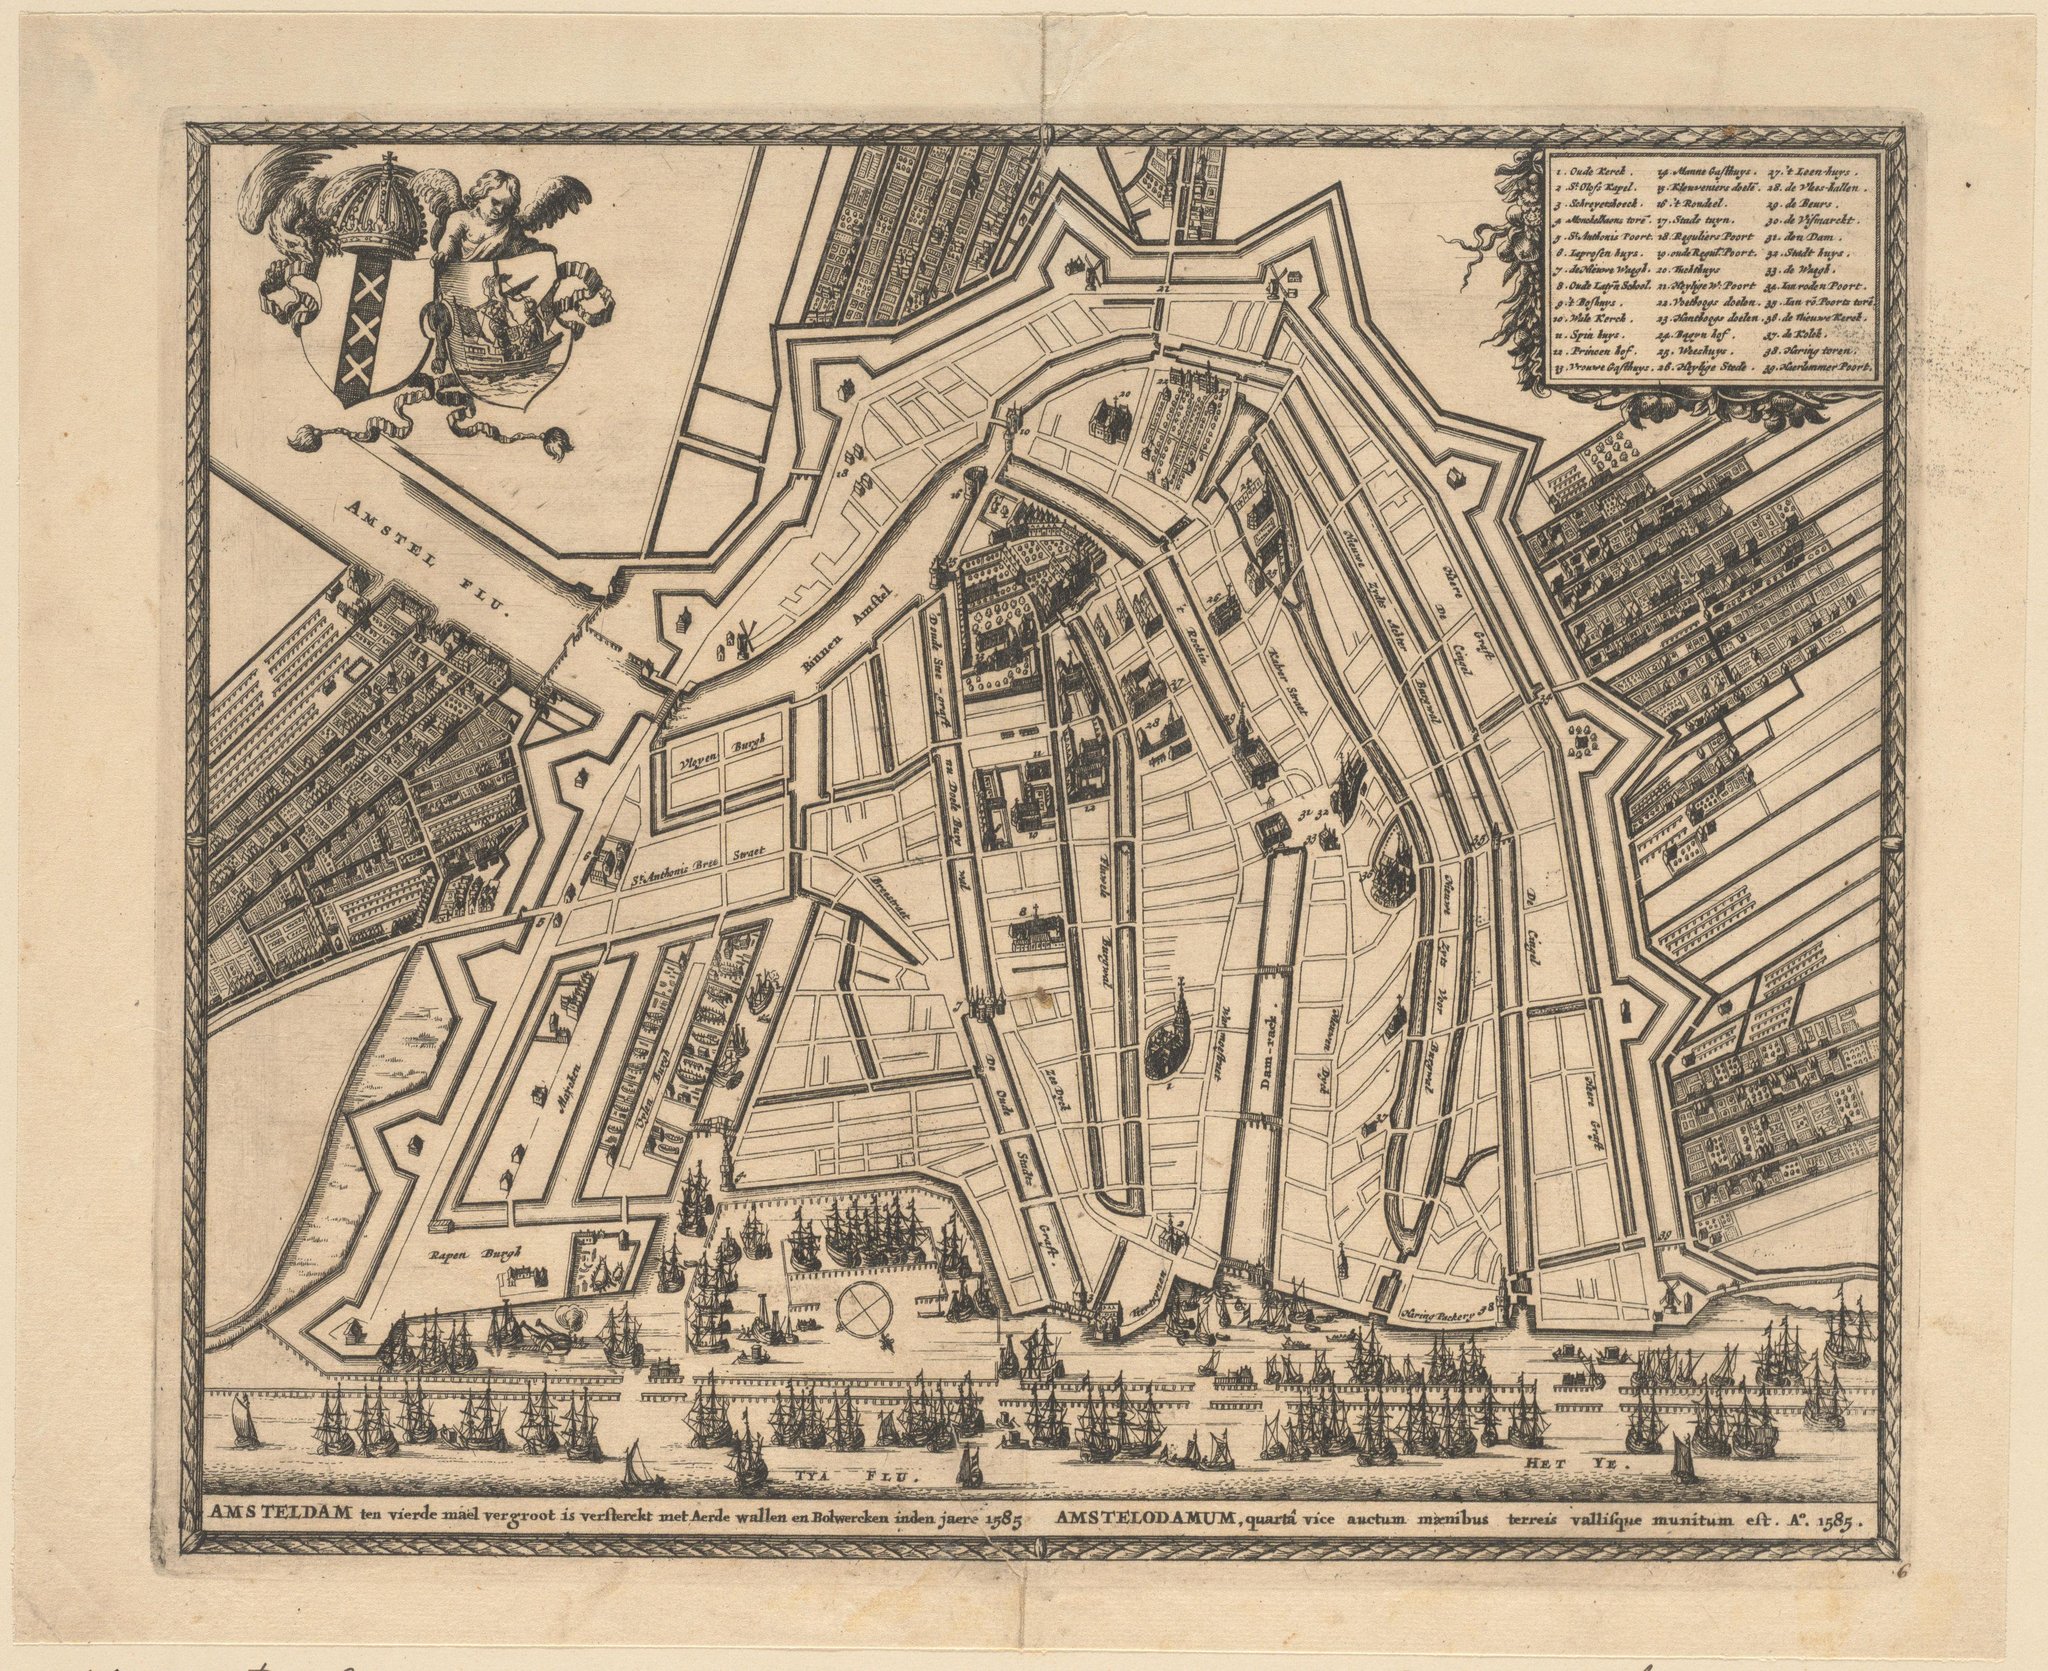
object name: map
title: Vier historische kaarten van Amsterdam (De Wit I)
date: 1680-1728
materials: paper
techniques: engraving, etching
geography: northern netherlands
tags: coat of arms (as symbol of the state, etc.) (+ city; municipal), maps of cities, amsterdam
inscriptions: collector's mark: Lugt 1641b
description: Prent mogelijk uit: La Celebre Ville d'Amsterdam (...) / De Heerlykheid der Wyd-vermaerde Stad Amsterdam (…). Leiden: Pieter (I) van der Aa, s.a. Of uit: Europa. Leiden: Pieter (I) van der Aa, [ca. 1715]. Of uit: La Galerie Agreable du Monde (...). Leiden: Pieter (I) van der Aa, 1728, dl. 17.